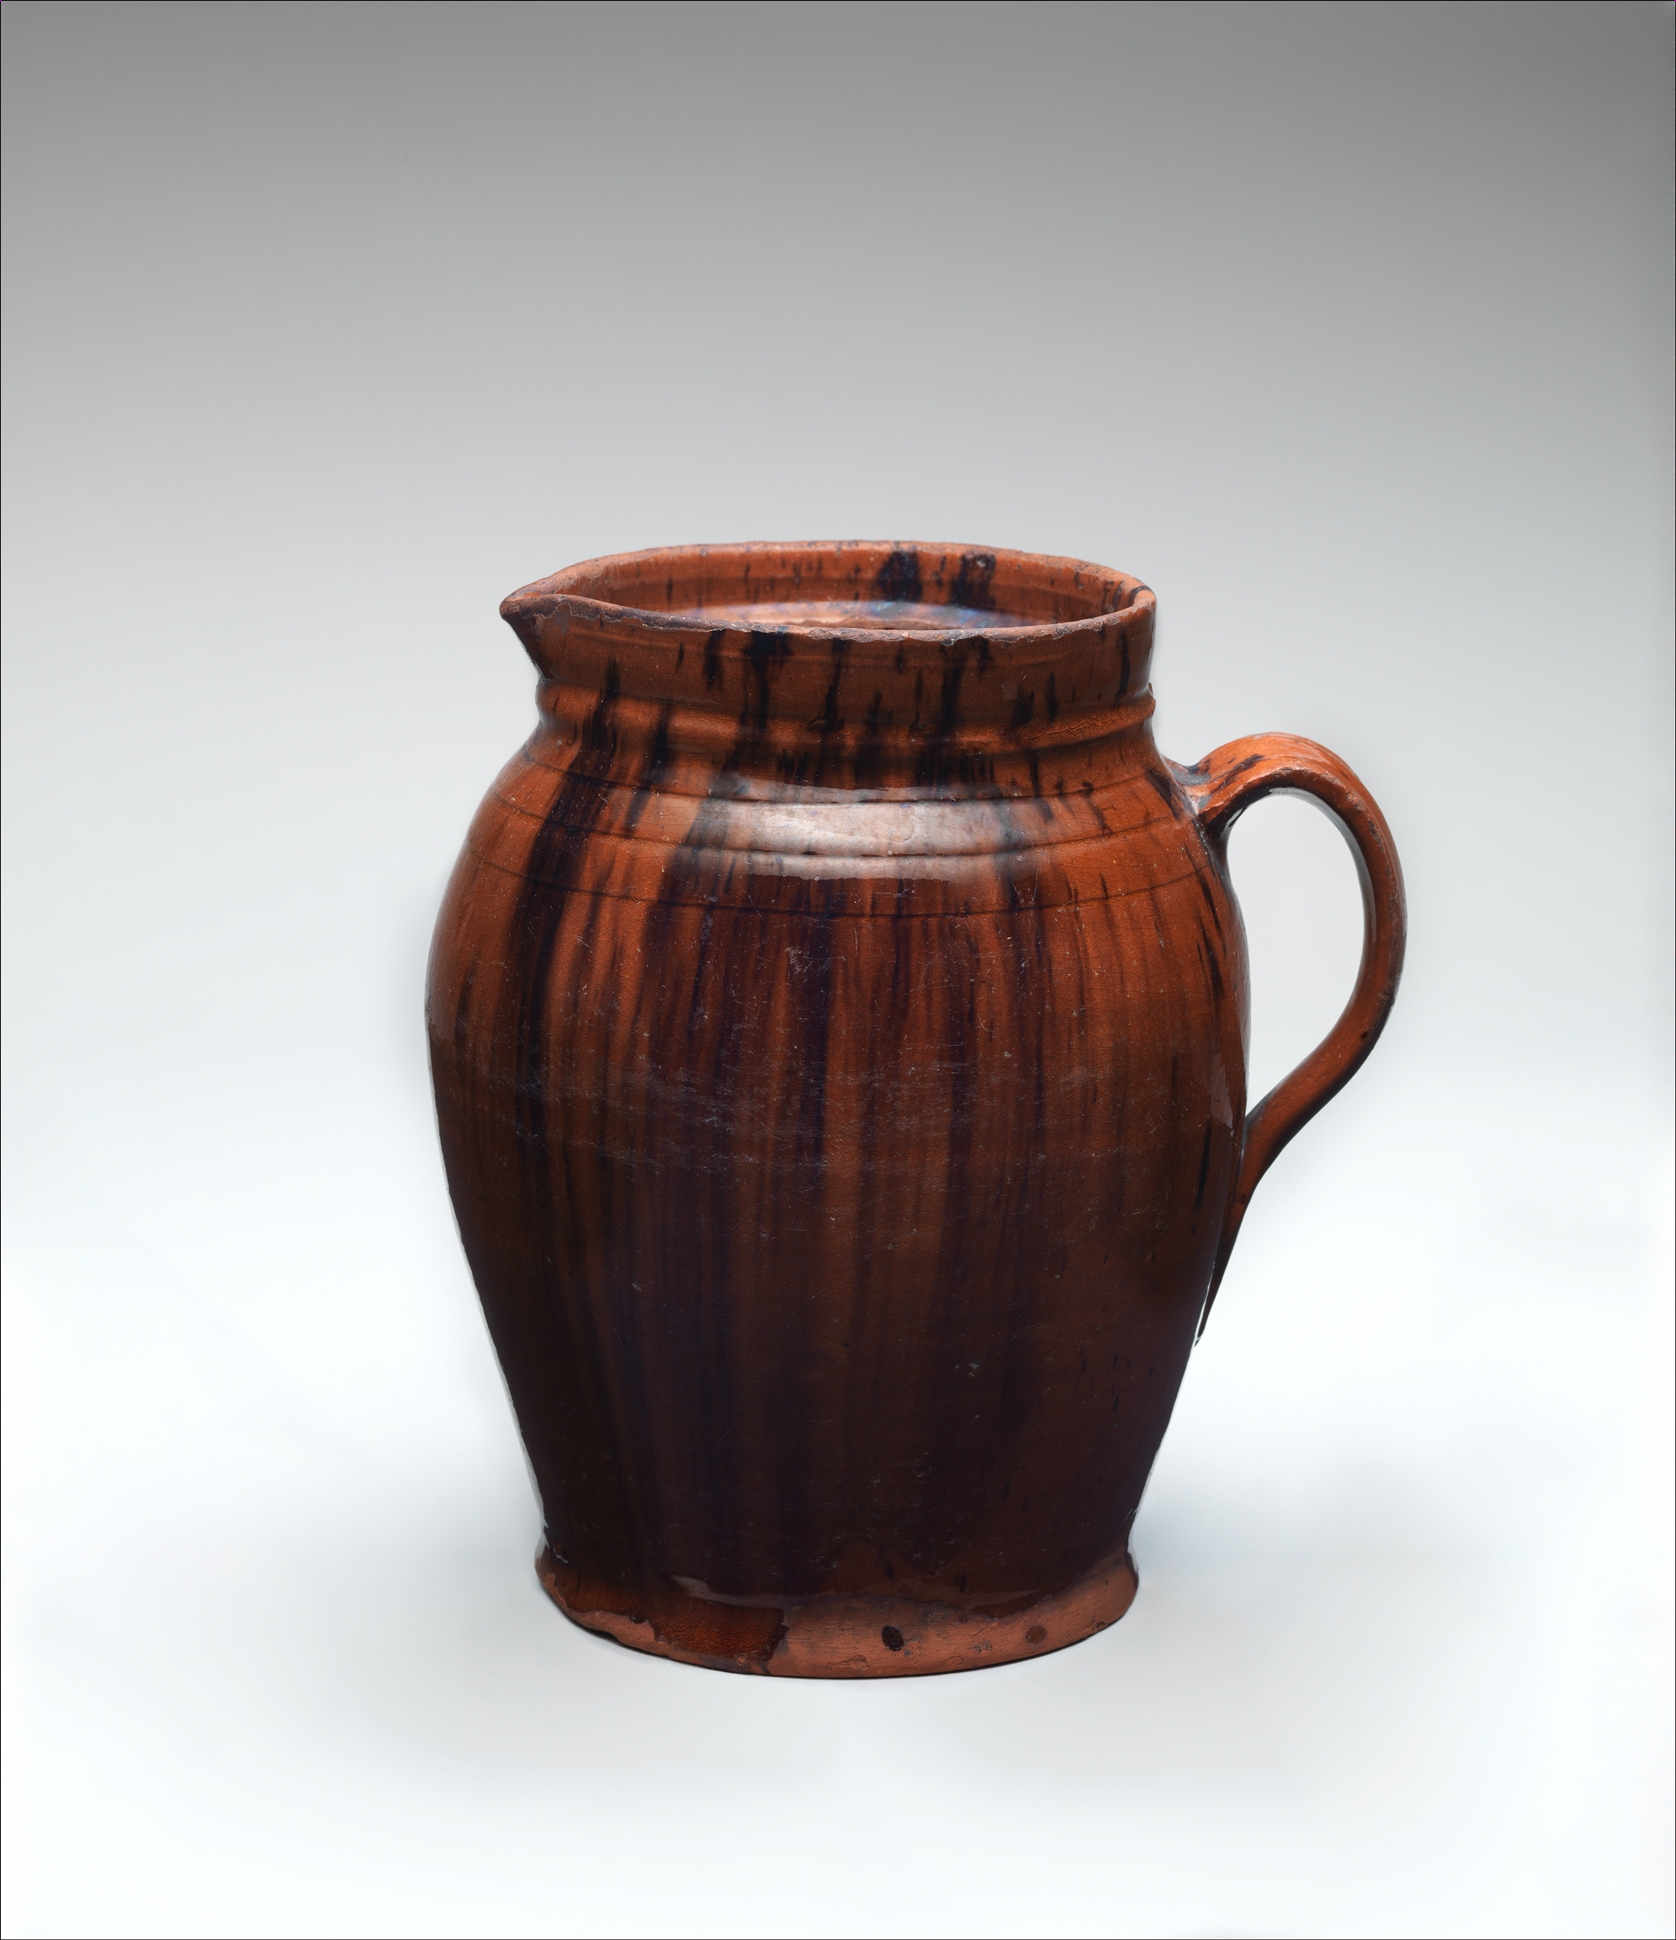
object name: pitcher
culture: american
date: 1700-1900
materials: earthenware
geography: united states